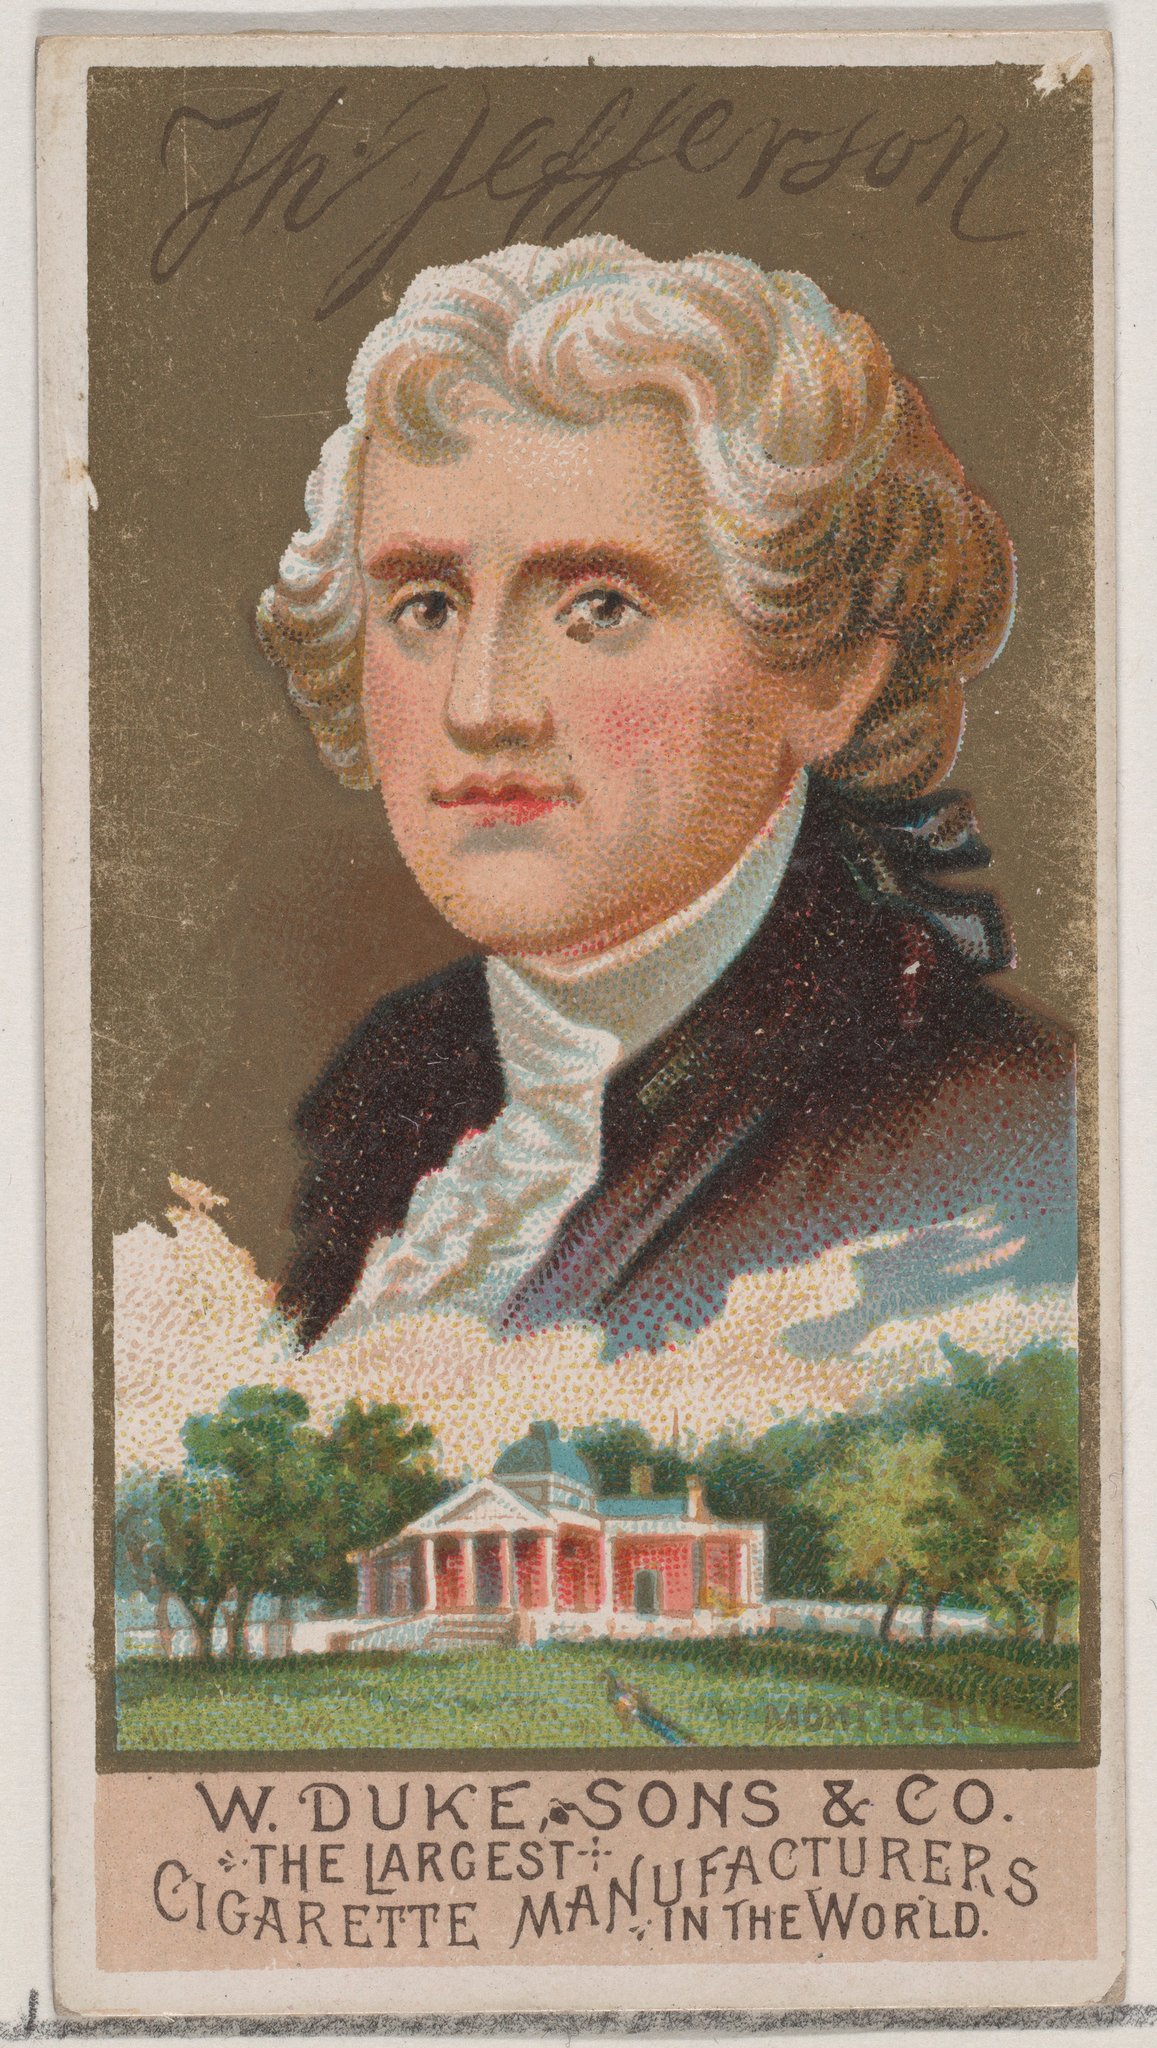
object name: print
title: Thomas Jefferson, from the series Great Americans (N76) for Duke brand cigarettes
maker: w. duke, sons & co.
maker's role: publisher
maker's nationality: american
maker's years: 1870-1920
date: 1888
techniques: color lithograph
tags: men